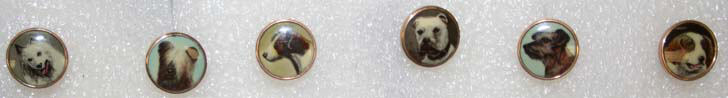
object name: button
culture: british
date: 1900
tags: dogs